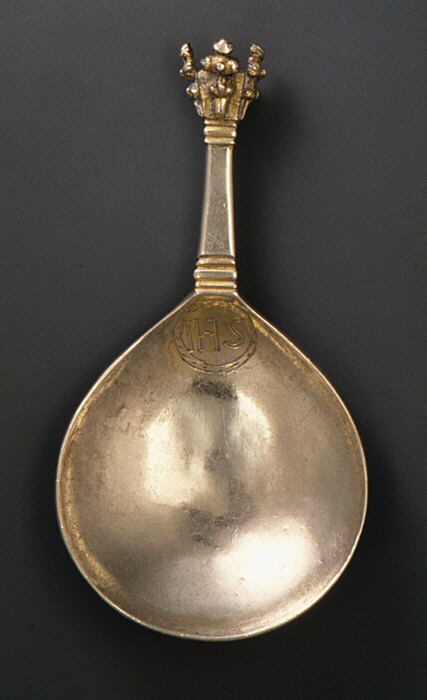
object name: spoon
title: Crown-top spoon (one of three)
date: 1501-1600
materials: gilt, silver